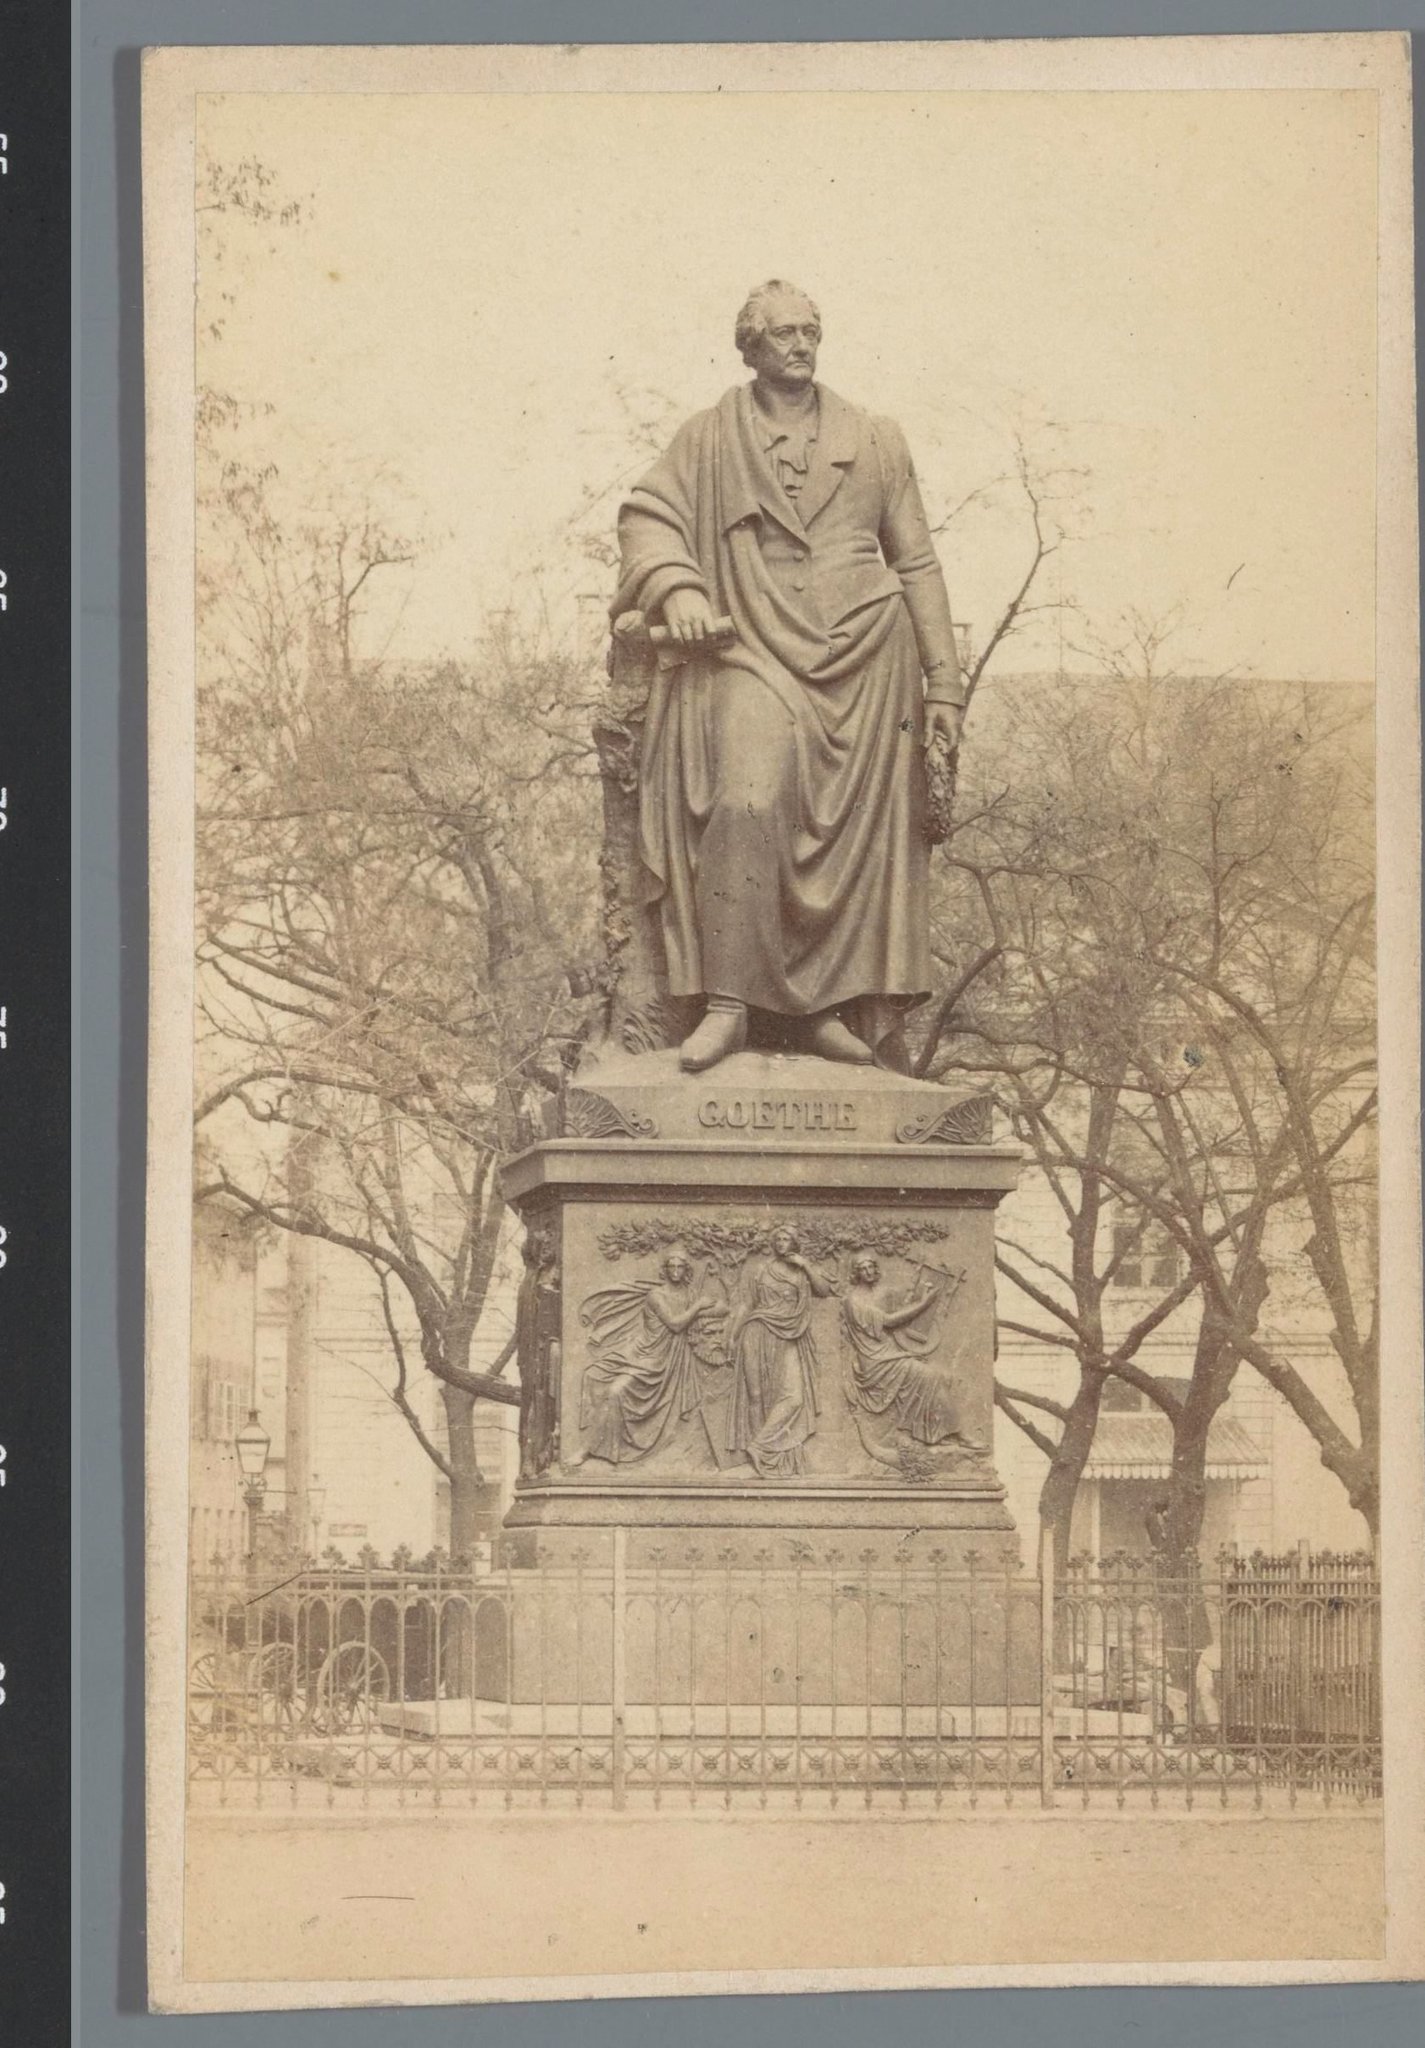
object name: photograph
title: Standbeeld van Goethe in Frankfurt am Main, Duitsland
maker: Anonymous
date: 1860-1875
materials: cardboard, paper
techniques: albumen print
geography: frankfurt am main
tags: draughtsman, johann wolfgang von goethe, monument, statue